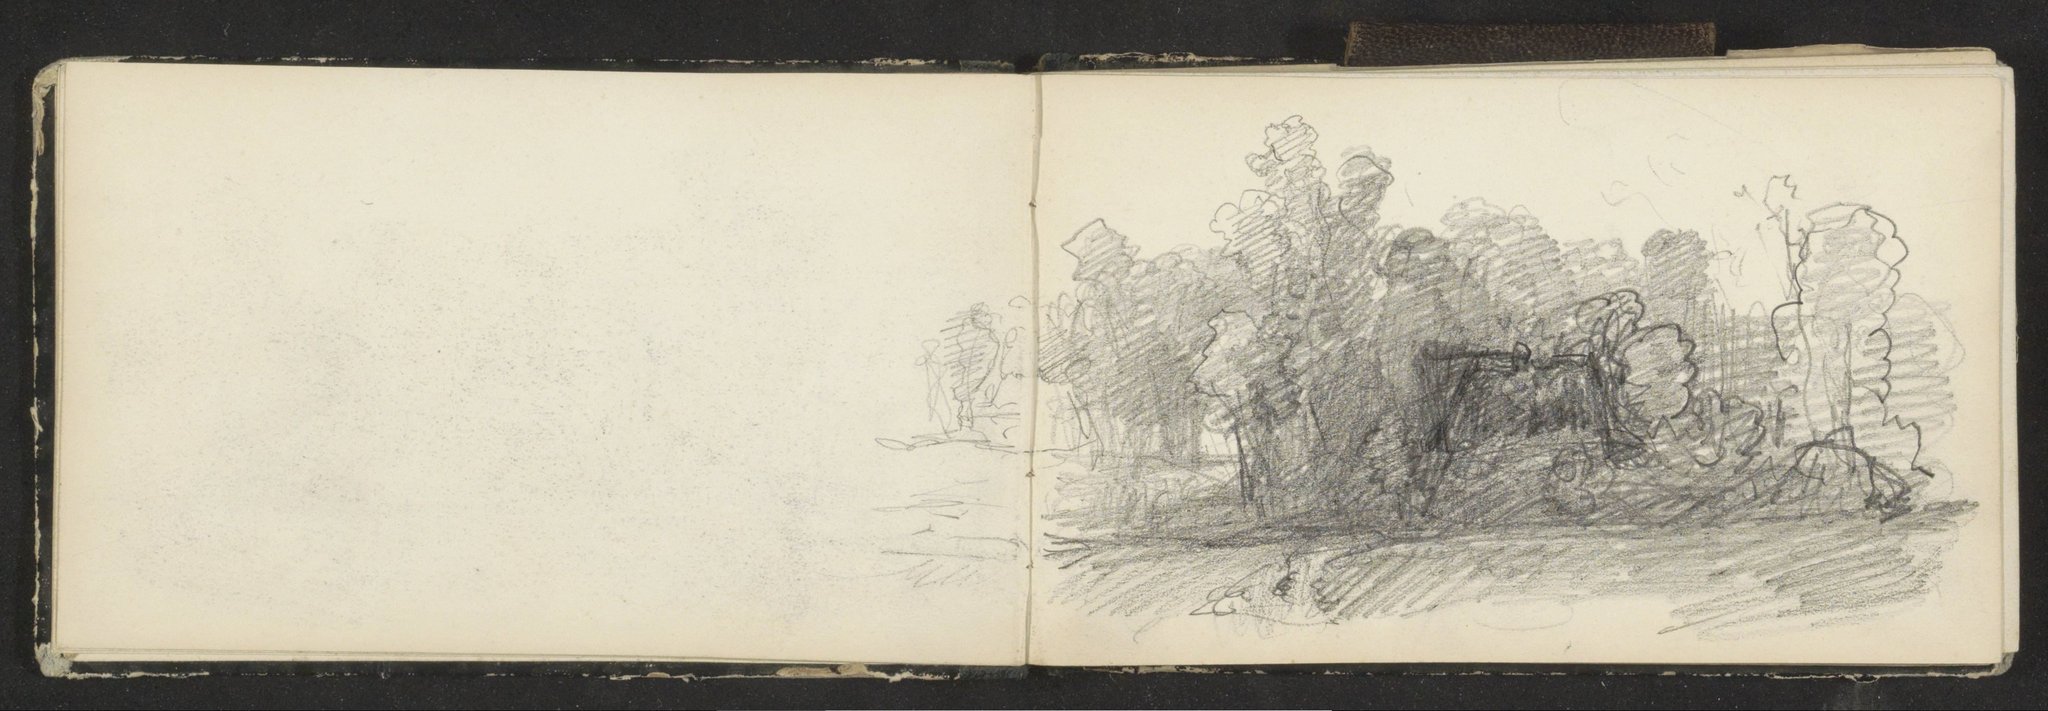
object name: sketchbook leaf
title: Landschap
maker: maria vos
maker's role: draughtsman, painter, print maker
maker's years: 1824-1906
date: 1834-1906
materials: paper, pencil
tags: landscapes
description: Blad 3 verso en 4 recto uit een schetsboek met 46 bladen.